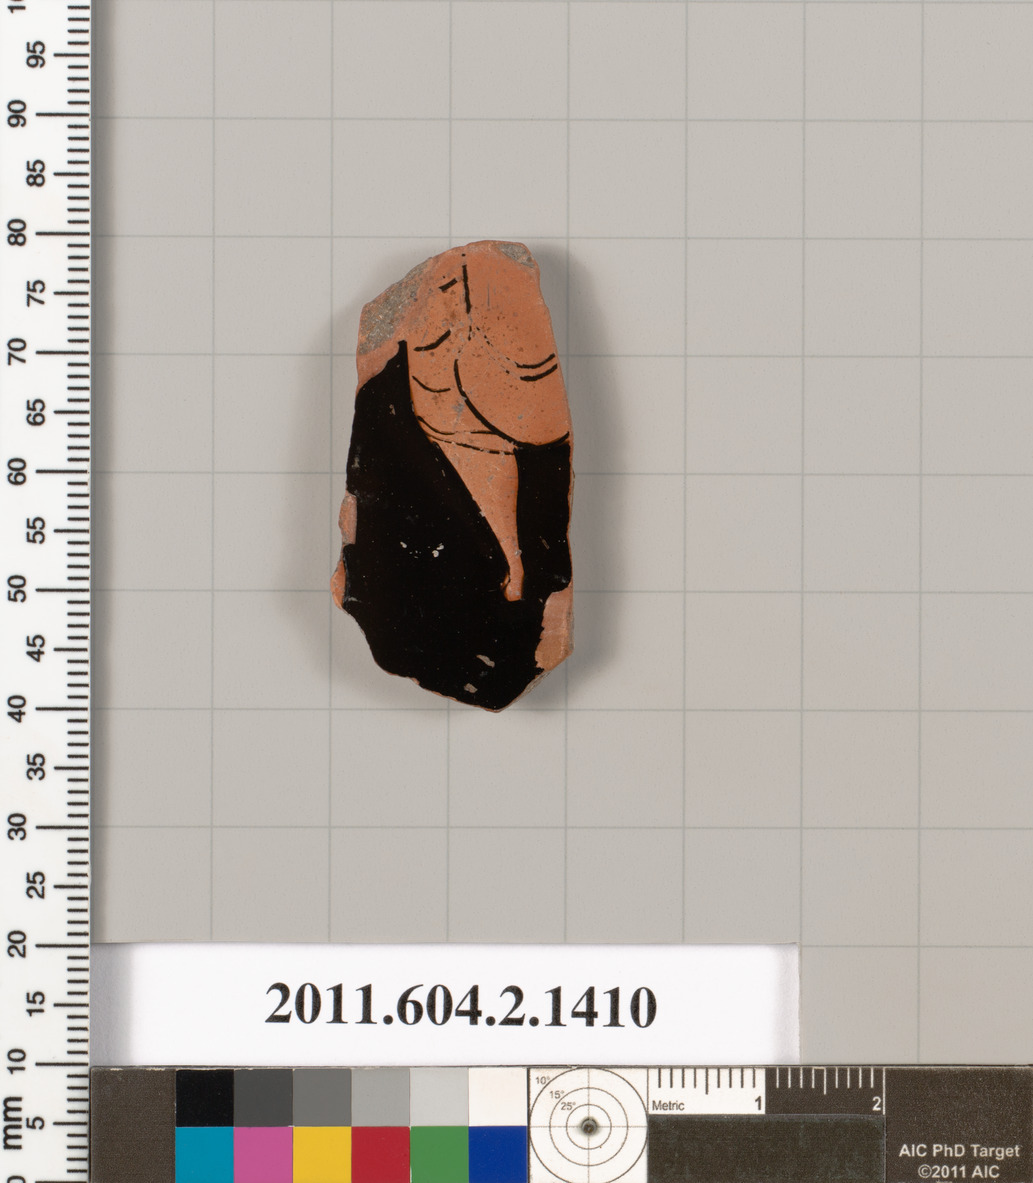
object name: skyphos fragment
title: Terracotta fragment of a skyphos (deep drinking cup)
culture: greek, attic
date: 490-480 BCE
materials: terracotta